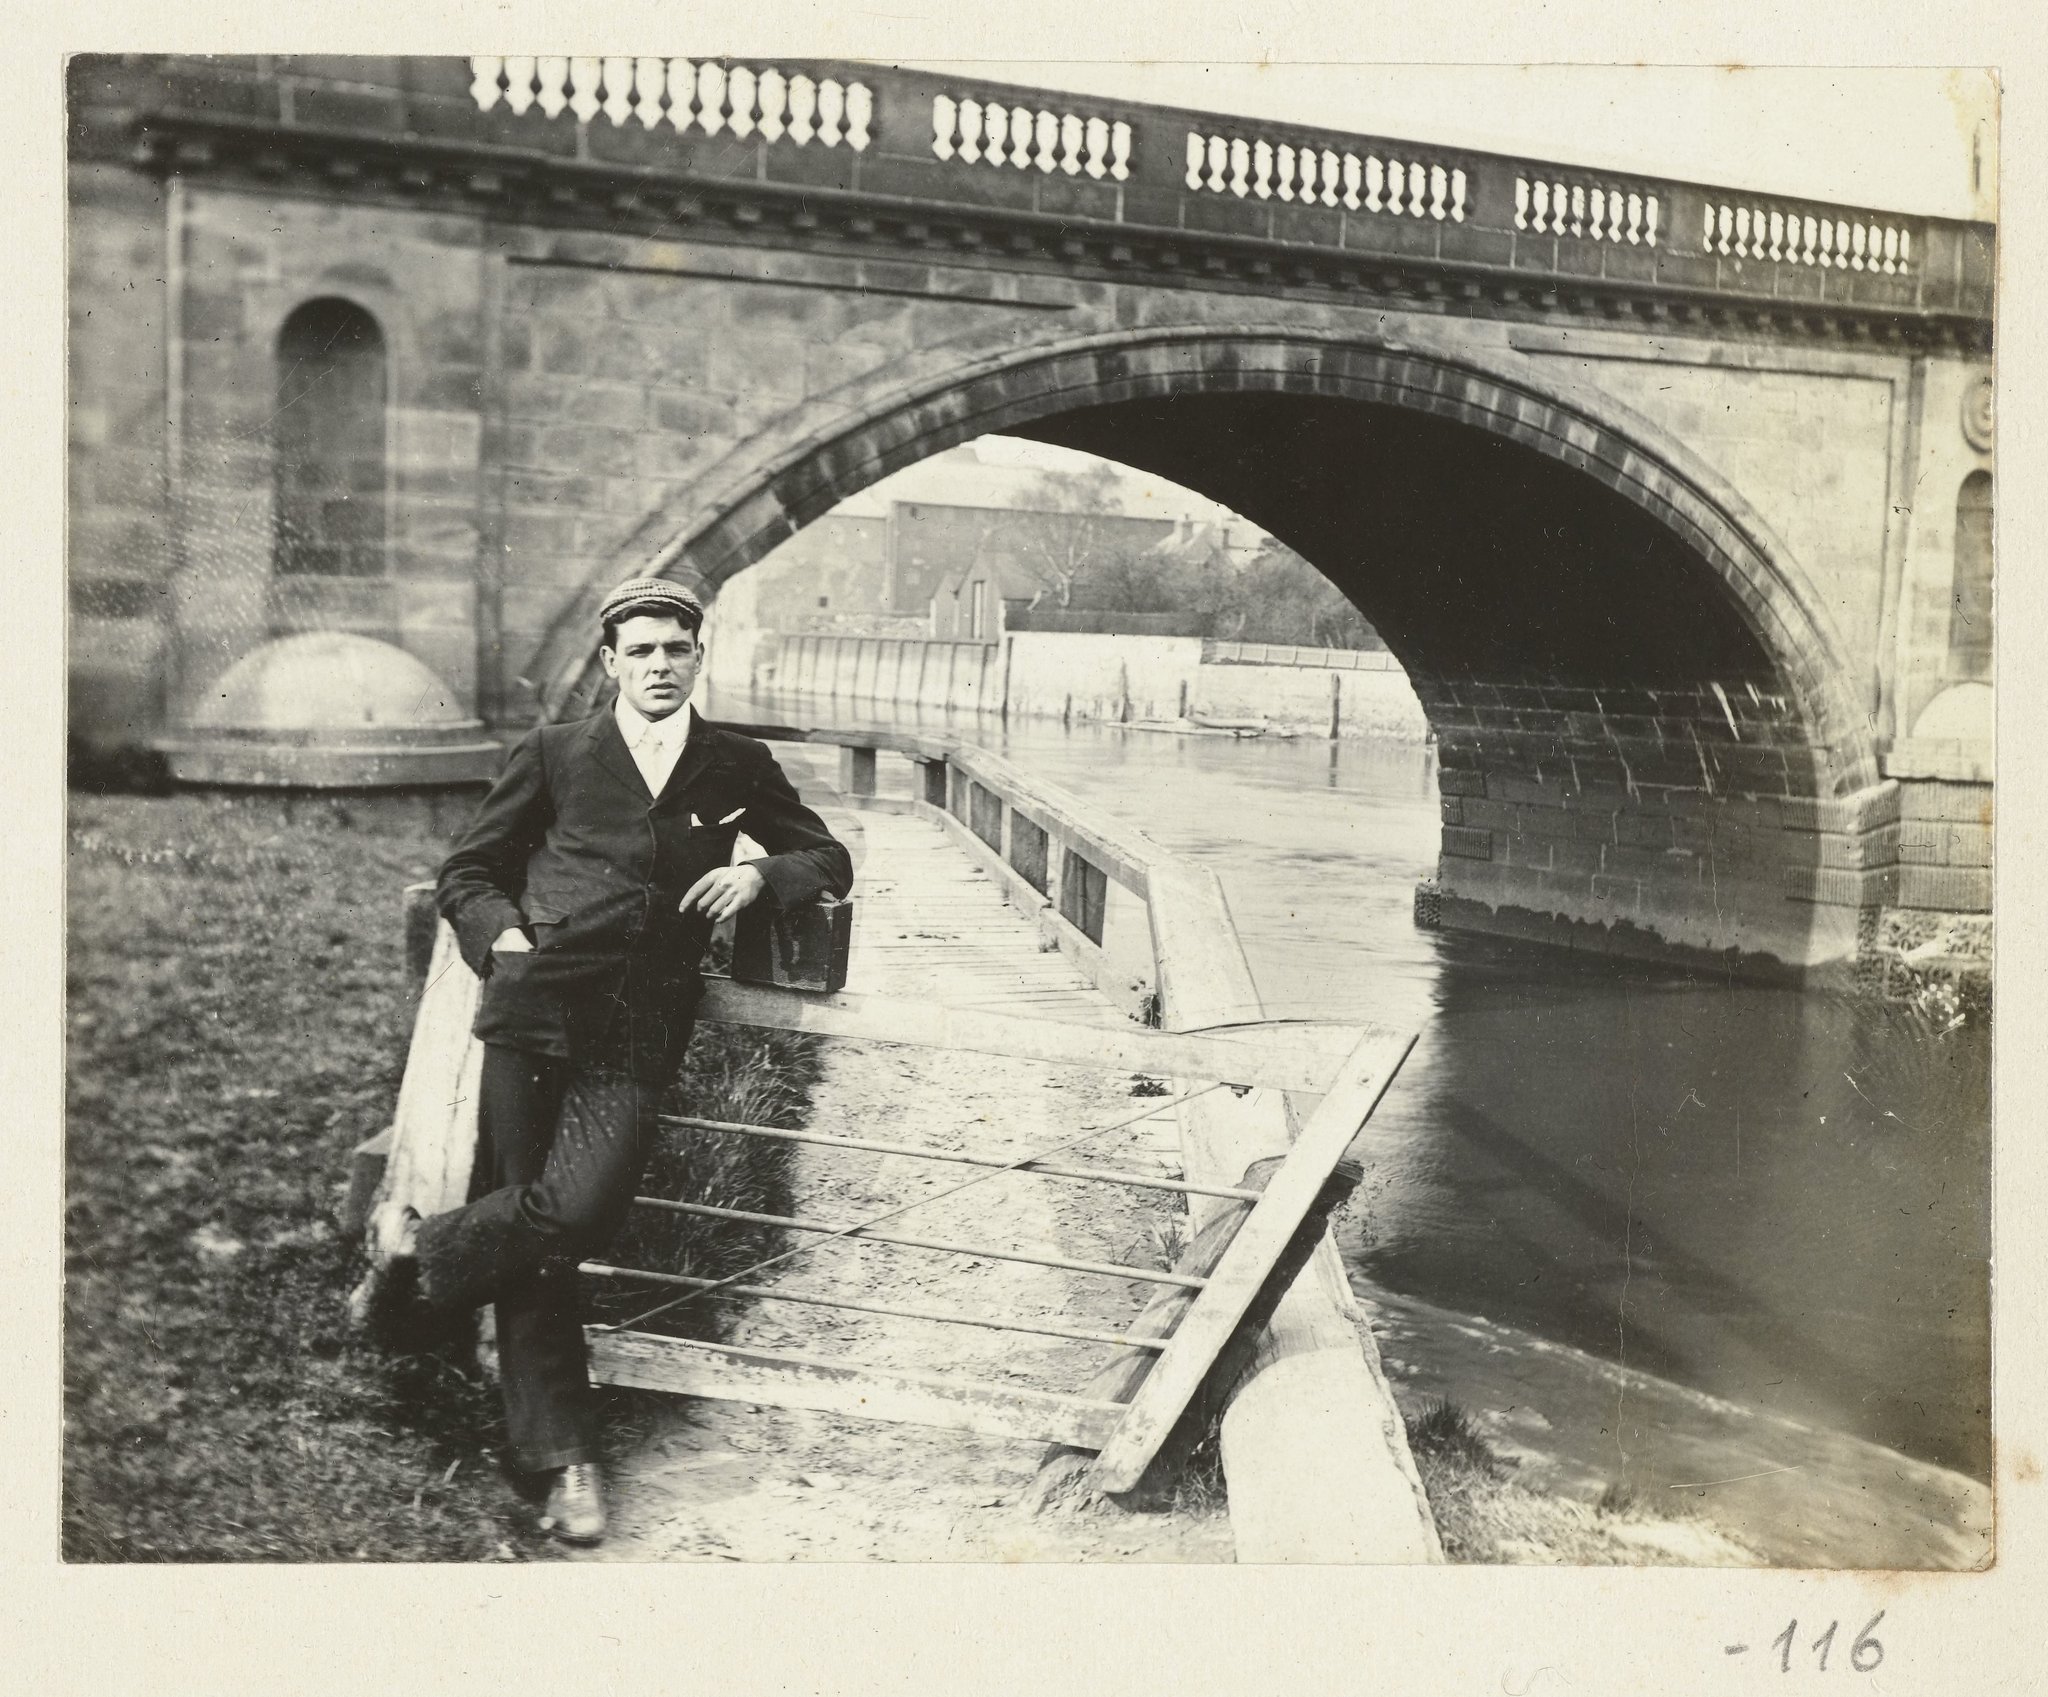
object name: photograph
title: Portret van een vriend van Dolph Kessler onder Gainsborough Bridge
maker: geldolph adriaan kessler (dolph)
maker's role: fotograaf, industrieel, voetballer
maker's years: 1884-1945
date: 1903-1904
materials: cardboard, photographic support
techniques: gelatin silver print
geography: gainsborough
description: Portret van een vriend van Dolph Kessler onder Gainsborough Bridge, op de achtergrond de rivier de Trent. Onderdeel van het fotoalbum van Dolph Kessler met opnamen die hij maakte tijdens zijn verblijf in Engeland en op een wereldreis die hij als secretaris van Henri Deterding (directeur Koninklijke Olie) ondernam naar Nederlands-Indië, Japan, China en de Verenigde Staten, tussen 1906 en 1908.